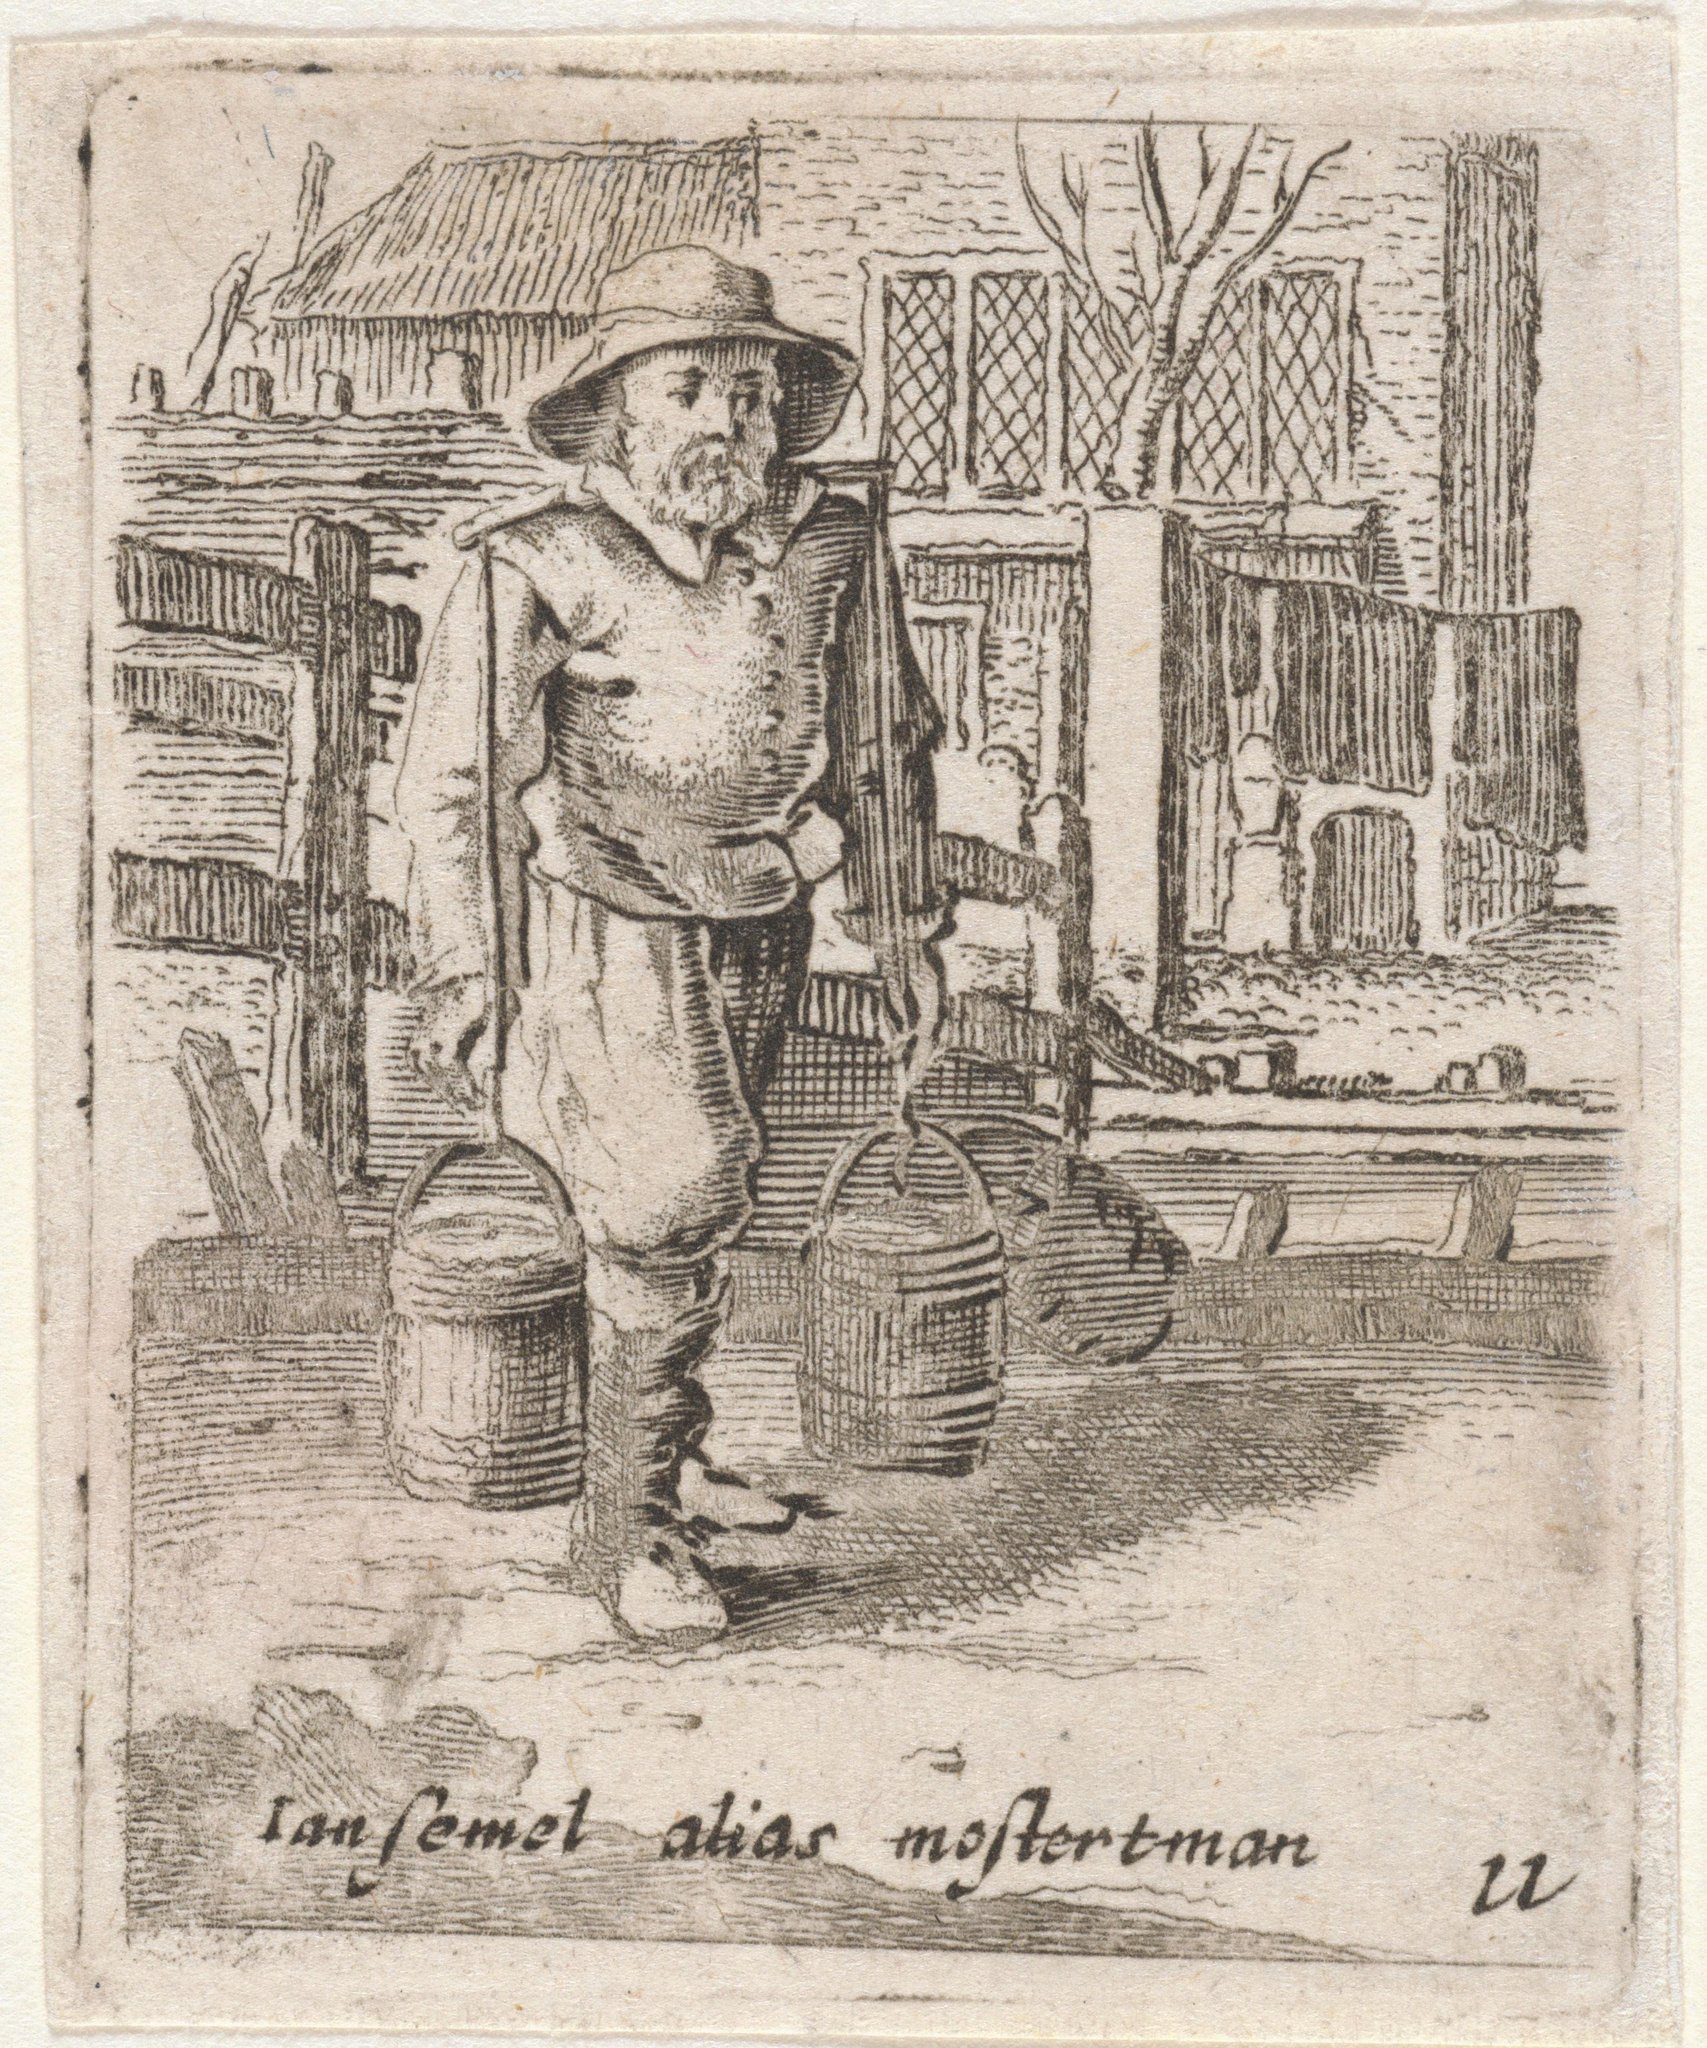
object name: print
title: Ian Semel alias mostertman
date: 1630-1706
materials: paper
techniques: engraving, etching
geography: netherlands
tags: carrying something with yoke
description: Een man (Ian Semel alias mostertman) draagt een juk met daaraan twee emmers. Op de achtergrond een houten brug en een huis. De prent maakt deel uit van een serie van 32 prenten met genretaferelen.